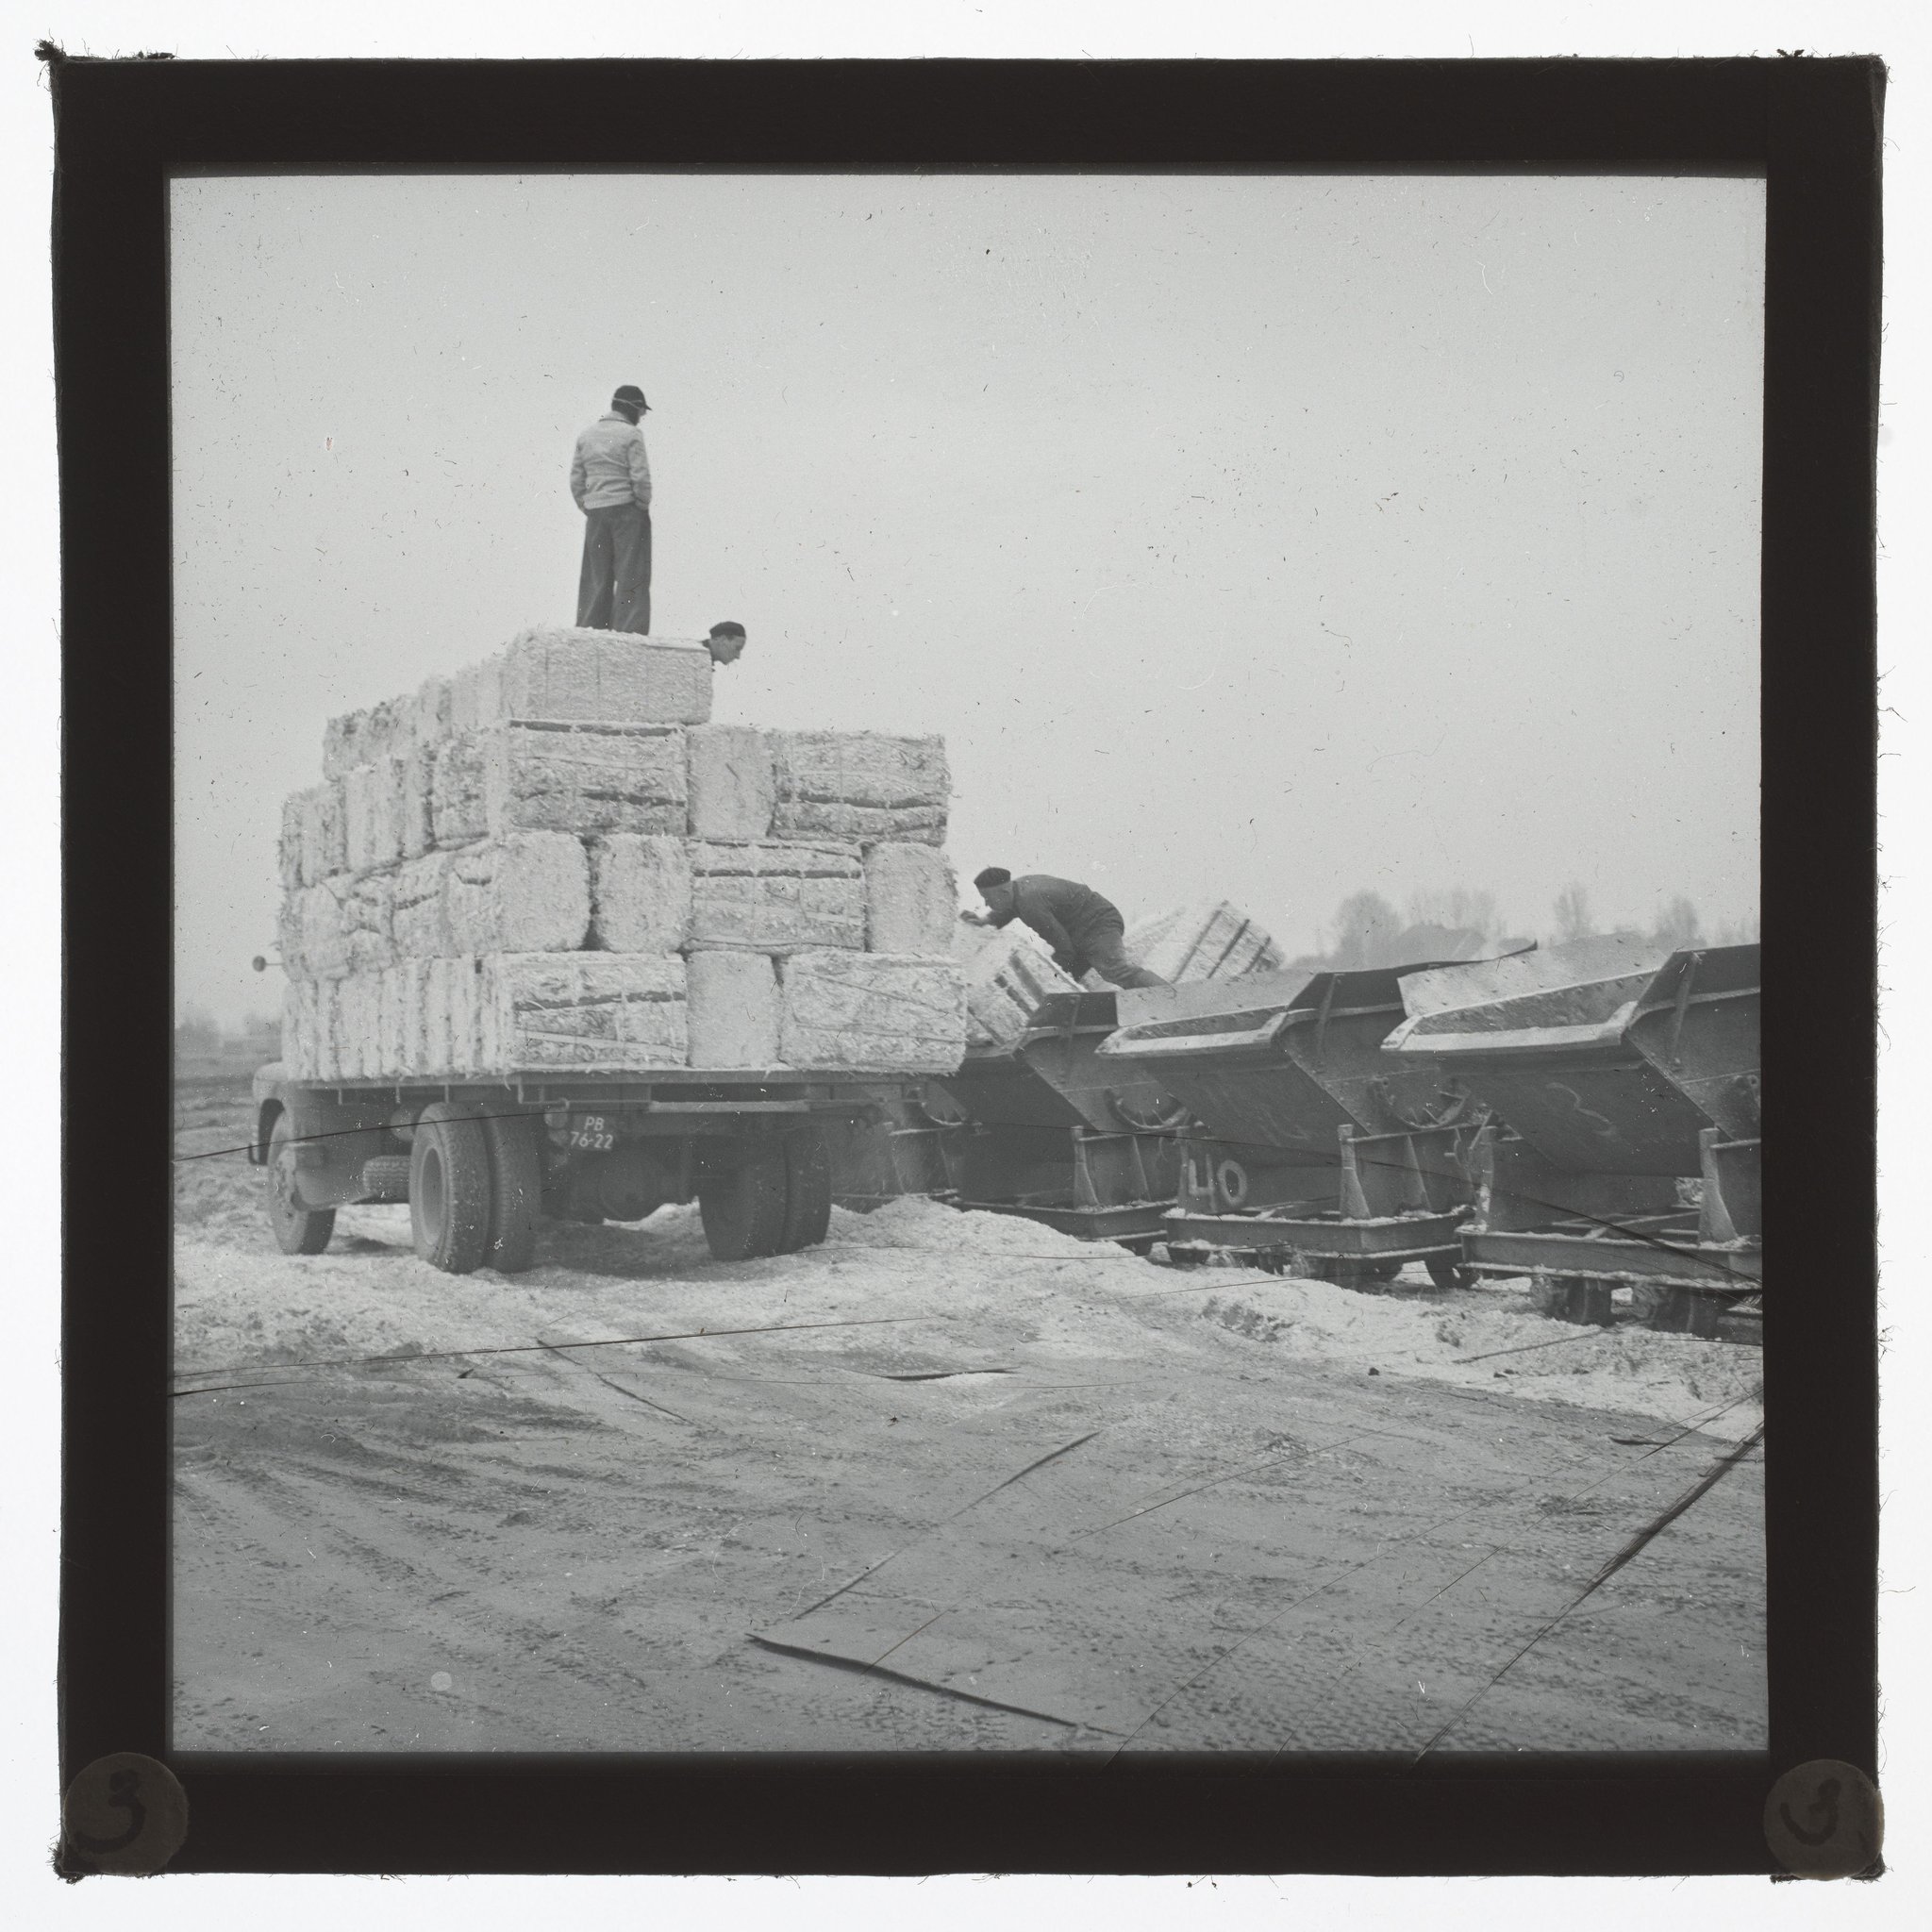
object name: lantern slide photographic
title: Mannen laden balen hooi van een vrachtwagen op een trein, Zuid-Holland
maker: Anonymous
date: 1956-1960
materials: glass, paper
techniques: gelatin silver transparency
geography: south holland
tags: truck, van, agricultural products and by-products: hay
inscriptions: number: ‘3’